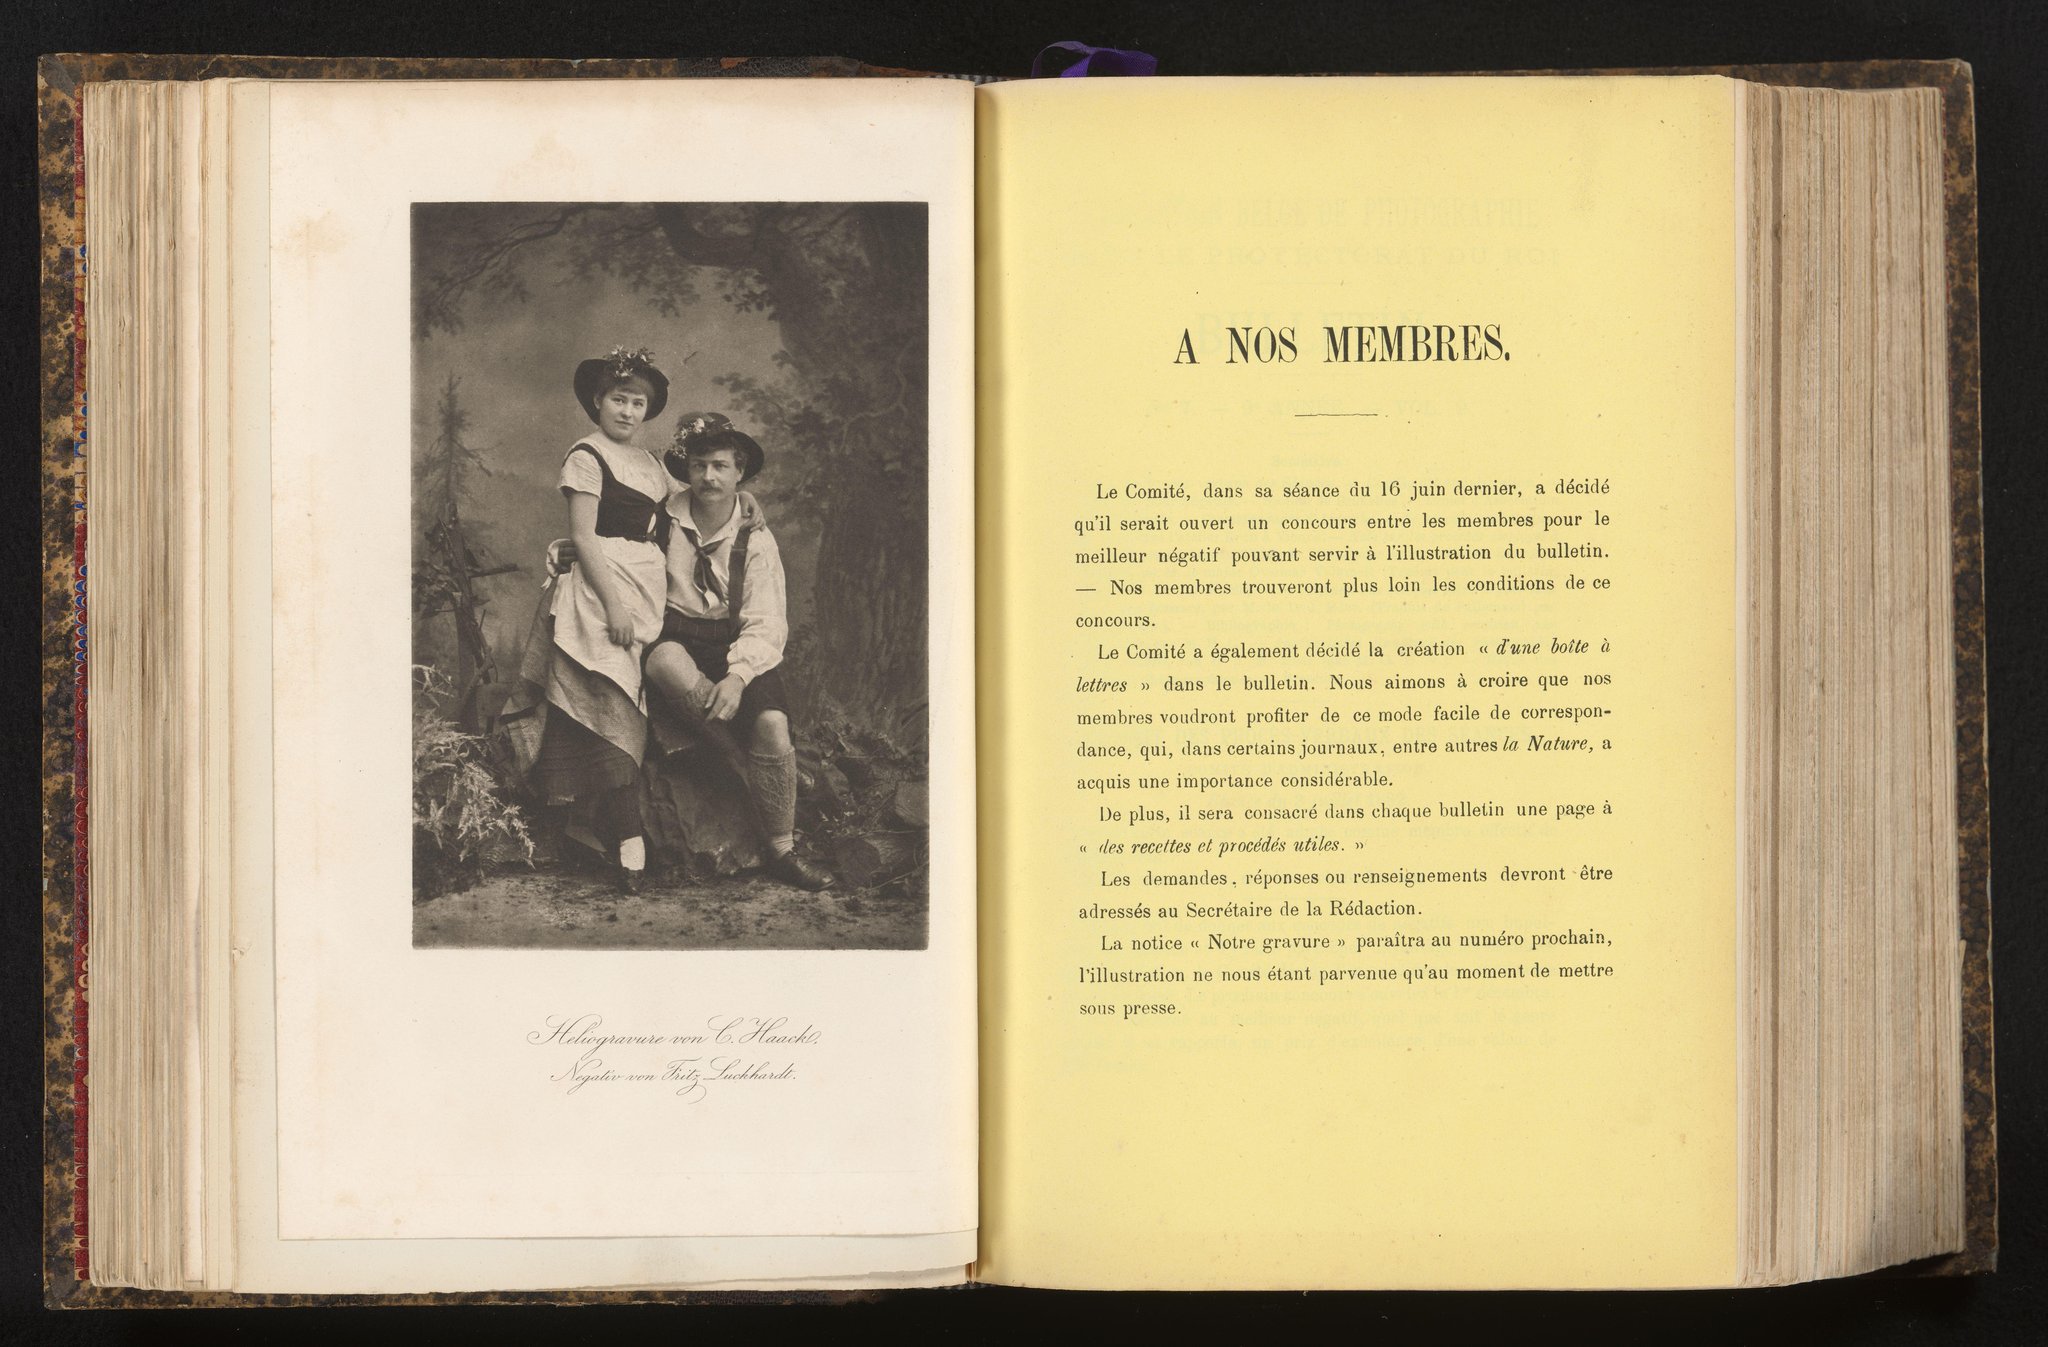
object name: photomechanical print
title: Portret van een onbekende man en vrouw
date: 1878-1883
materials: paper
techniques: photoaquatint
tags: adult woman, adult man